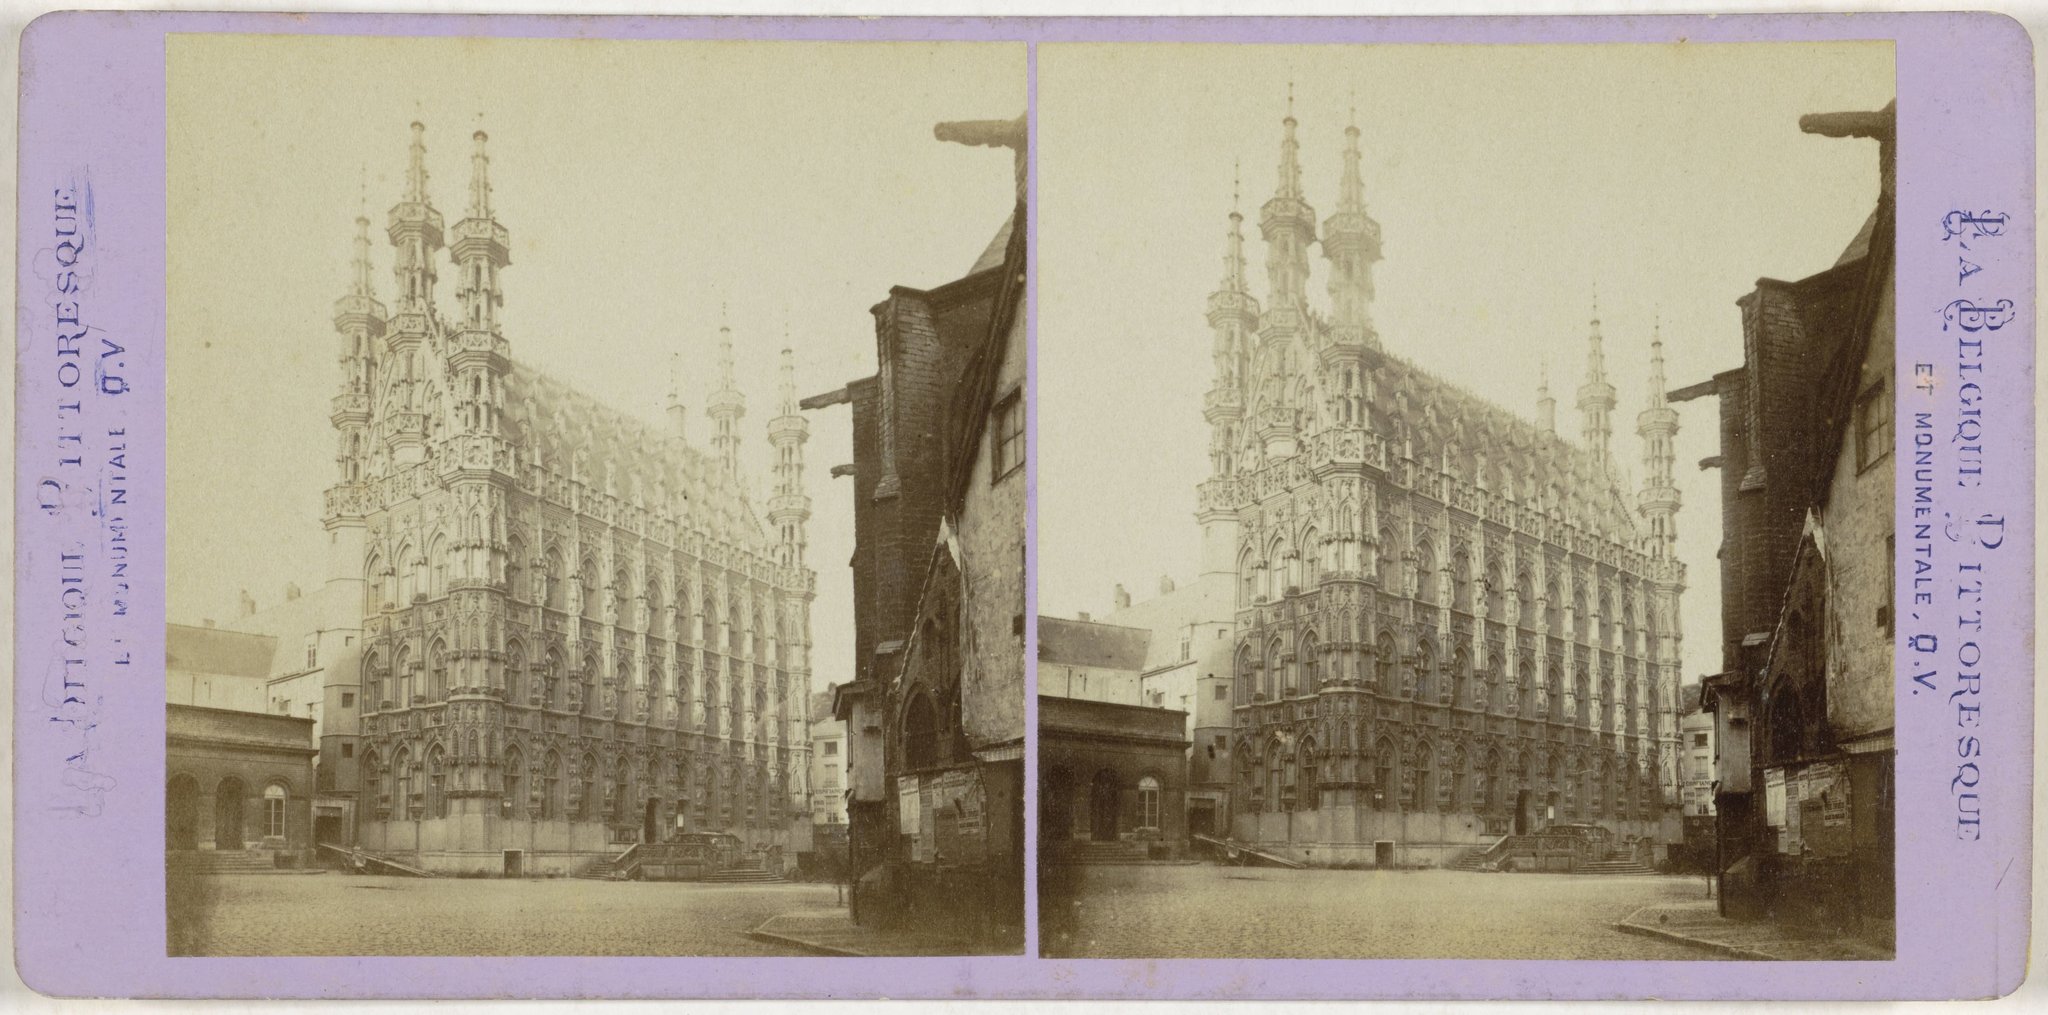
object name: stereograph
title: La Belgique pittoresque et monumentale / Views of Belgium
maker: jules hippolyte quéval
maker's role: publisher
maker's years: 1824-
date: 1866-1870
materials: cardboard, paper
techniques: albumen print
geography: leuven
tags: townhall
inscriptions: number: ‘No 1722’